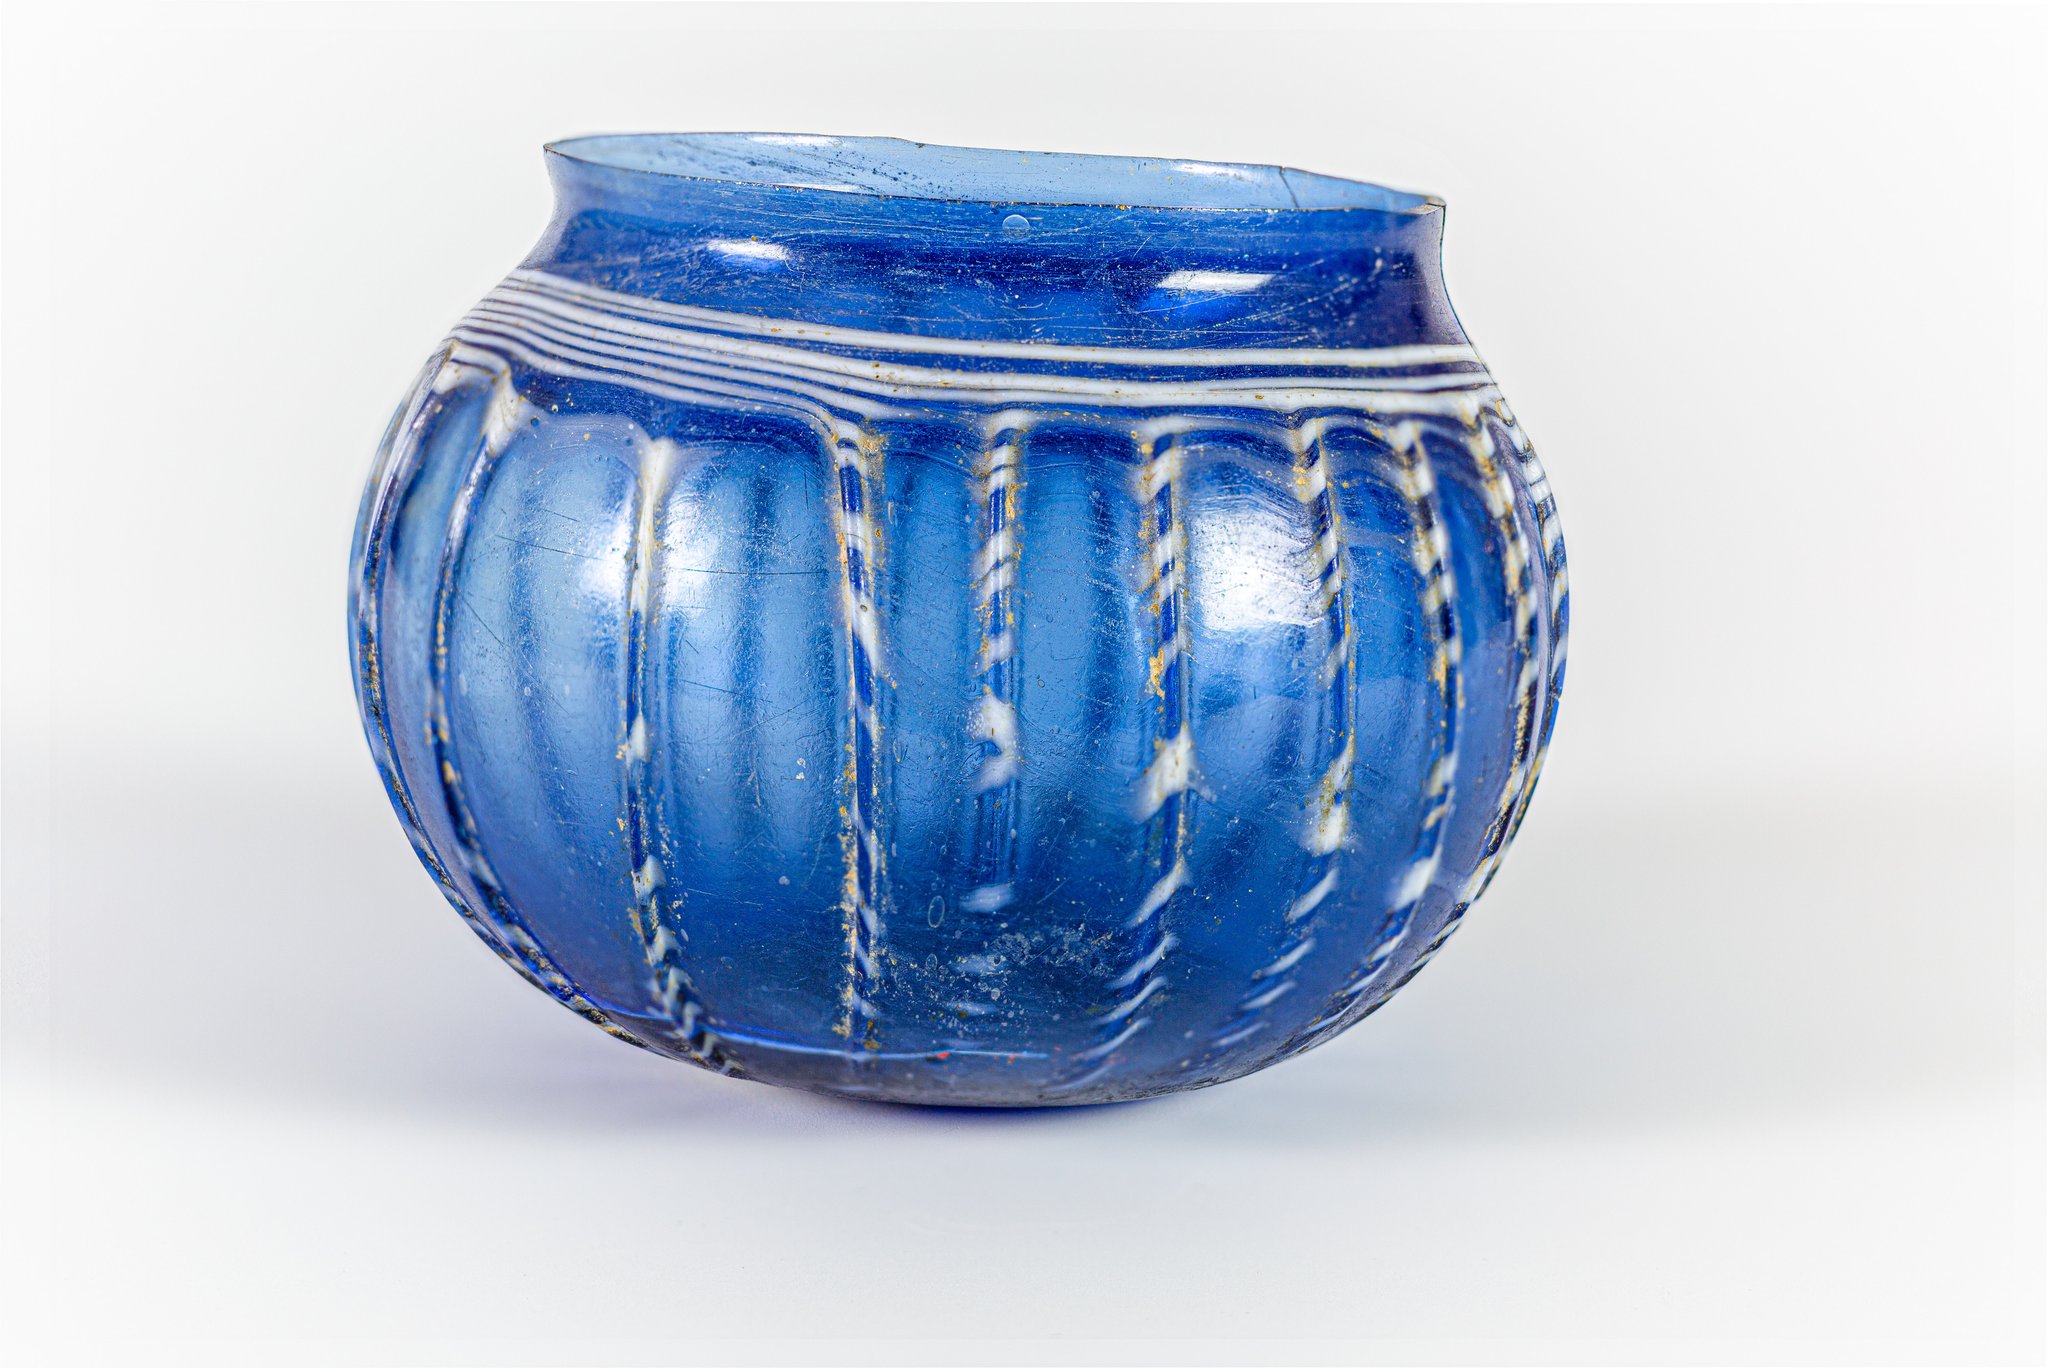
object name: bowl, rippenschale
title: Glass ribbed bowl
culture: roman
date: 34-66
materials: glass